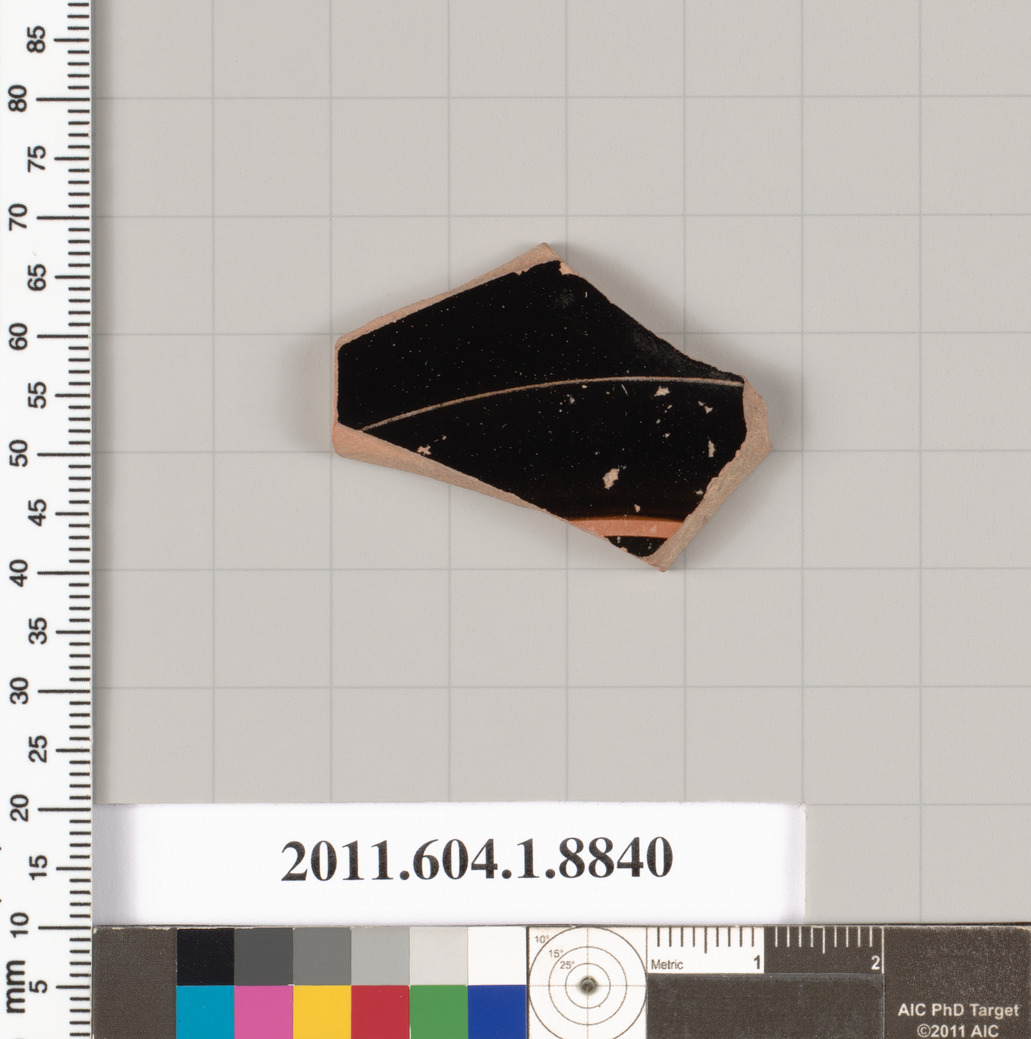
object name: kylix fragment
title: Terracotta fragment of a kylix (drinking cup)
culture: greek, attic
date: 490-480 BCE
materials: terracotta